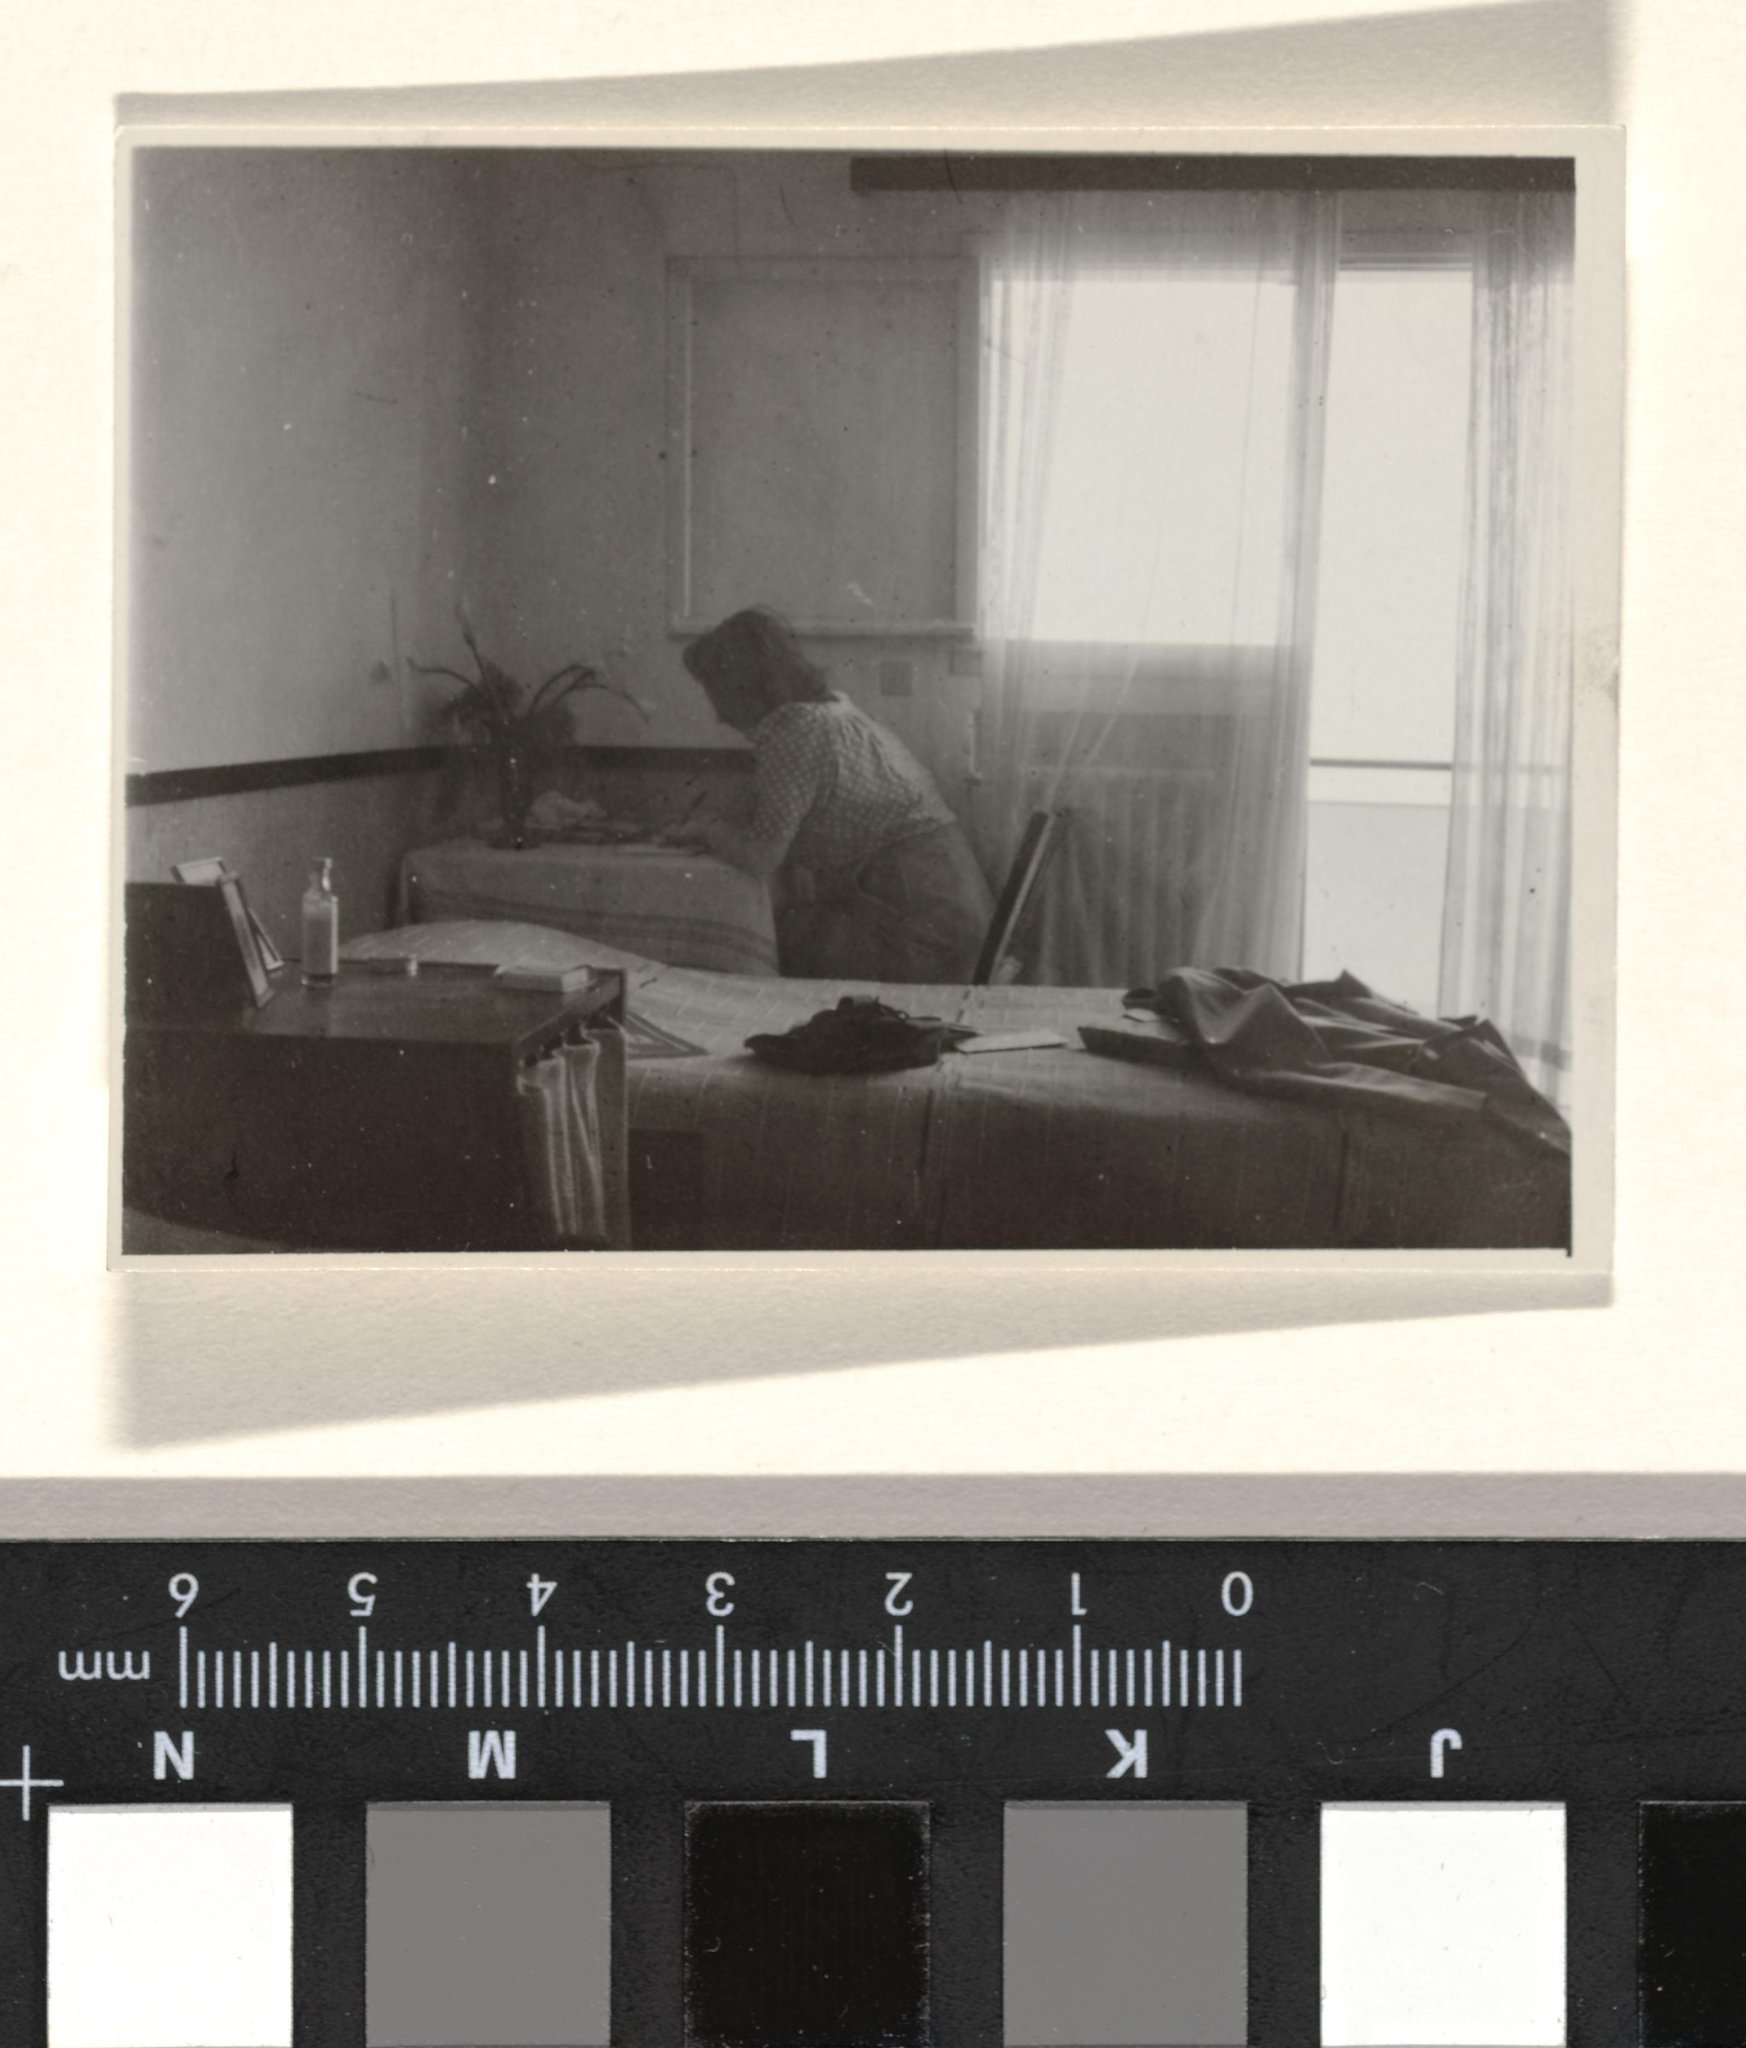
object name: photograph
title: Isabel Wachenheimer gezeten voor een open raam met gordijnen voor een bed, schrijvend aan een tafel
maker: Anonymous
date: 1945-1963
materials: photographic support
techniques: gelatin silver print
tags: leiden, isabel wachenheimer-elon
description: Isabel Wachenheimer gezeten voor een open raam met gordijnen voor een bed, schrijvend aan een tafel.